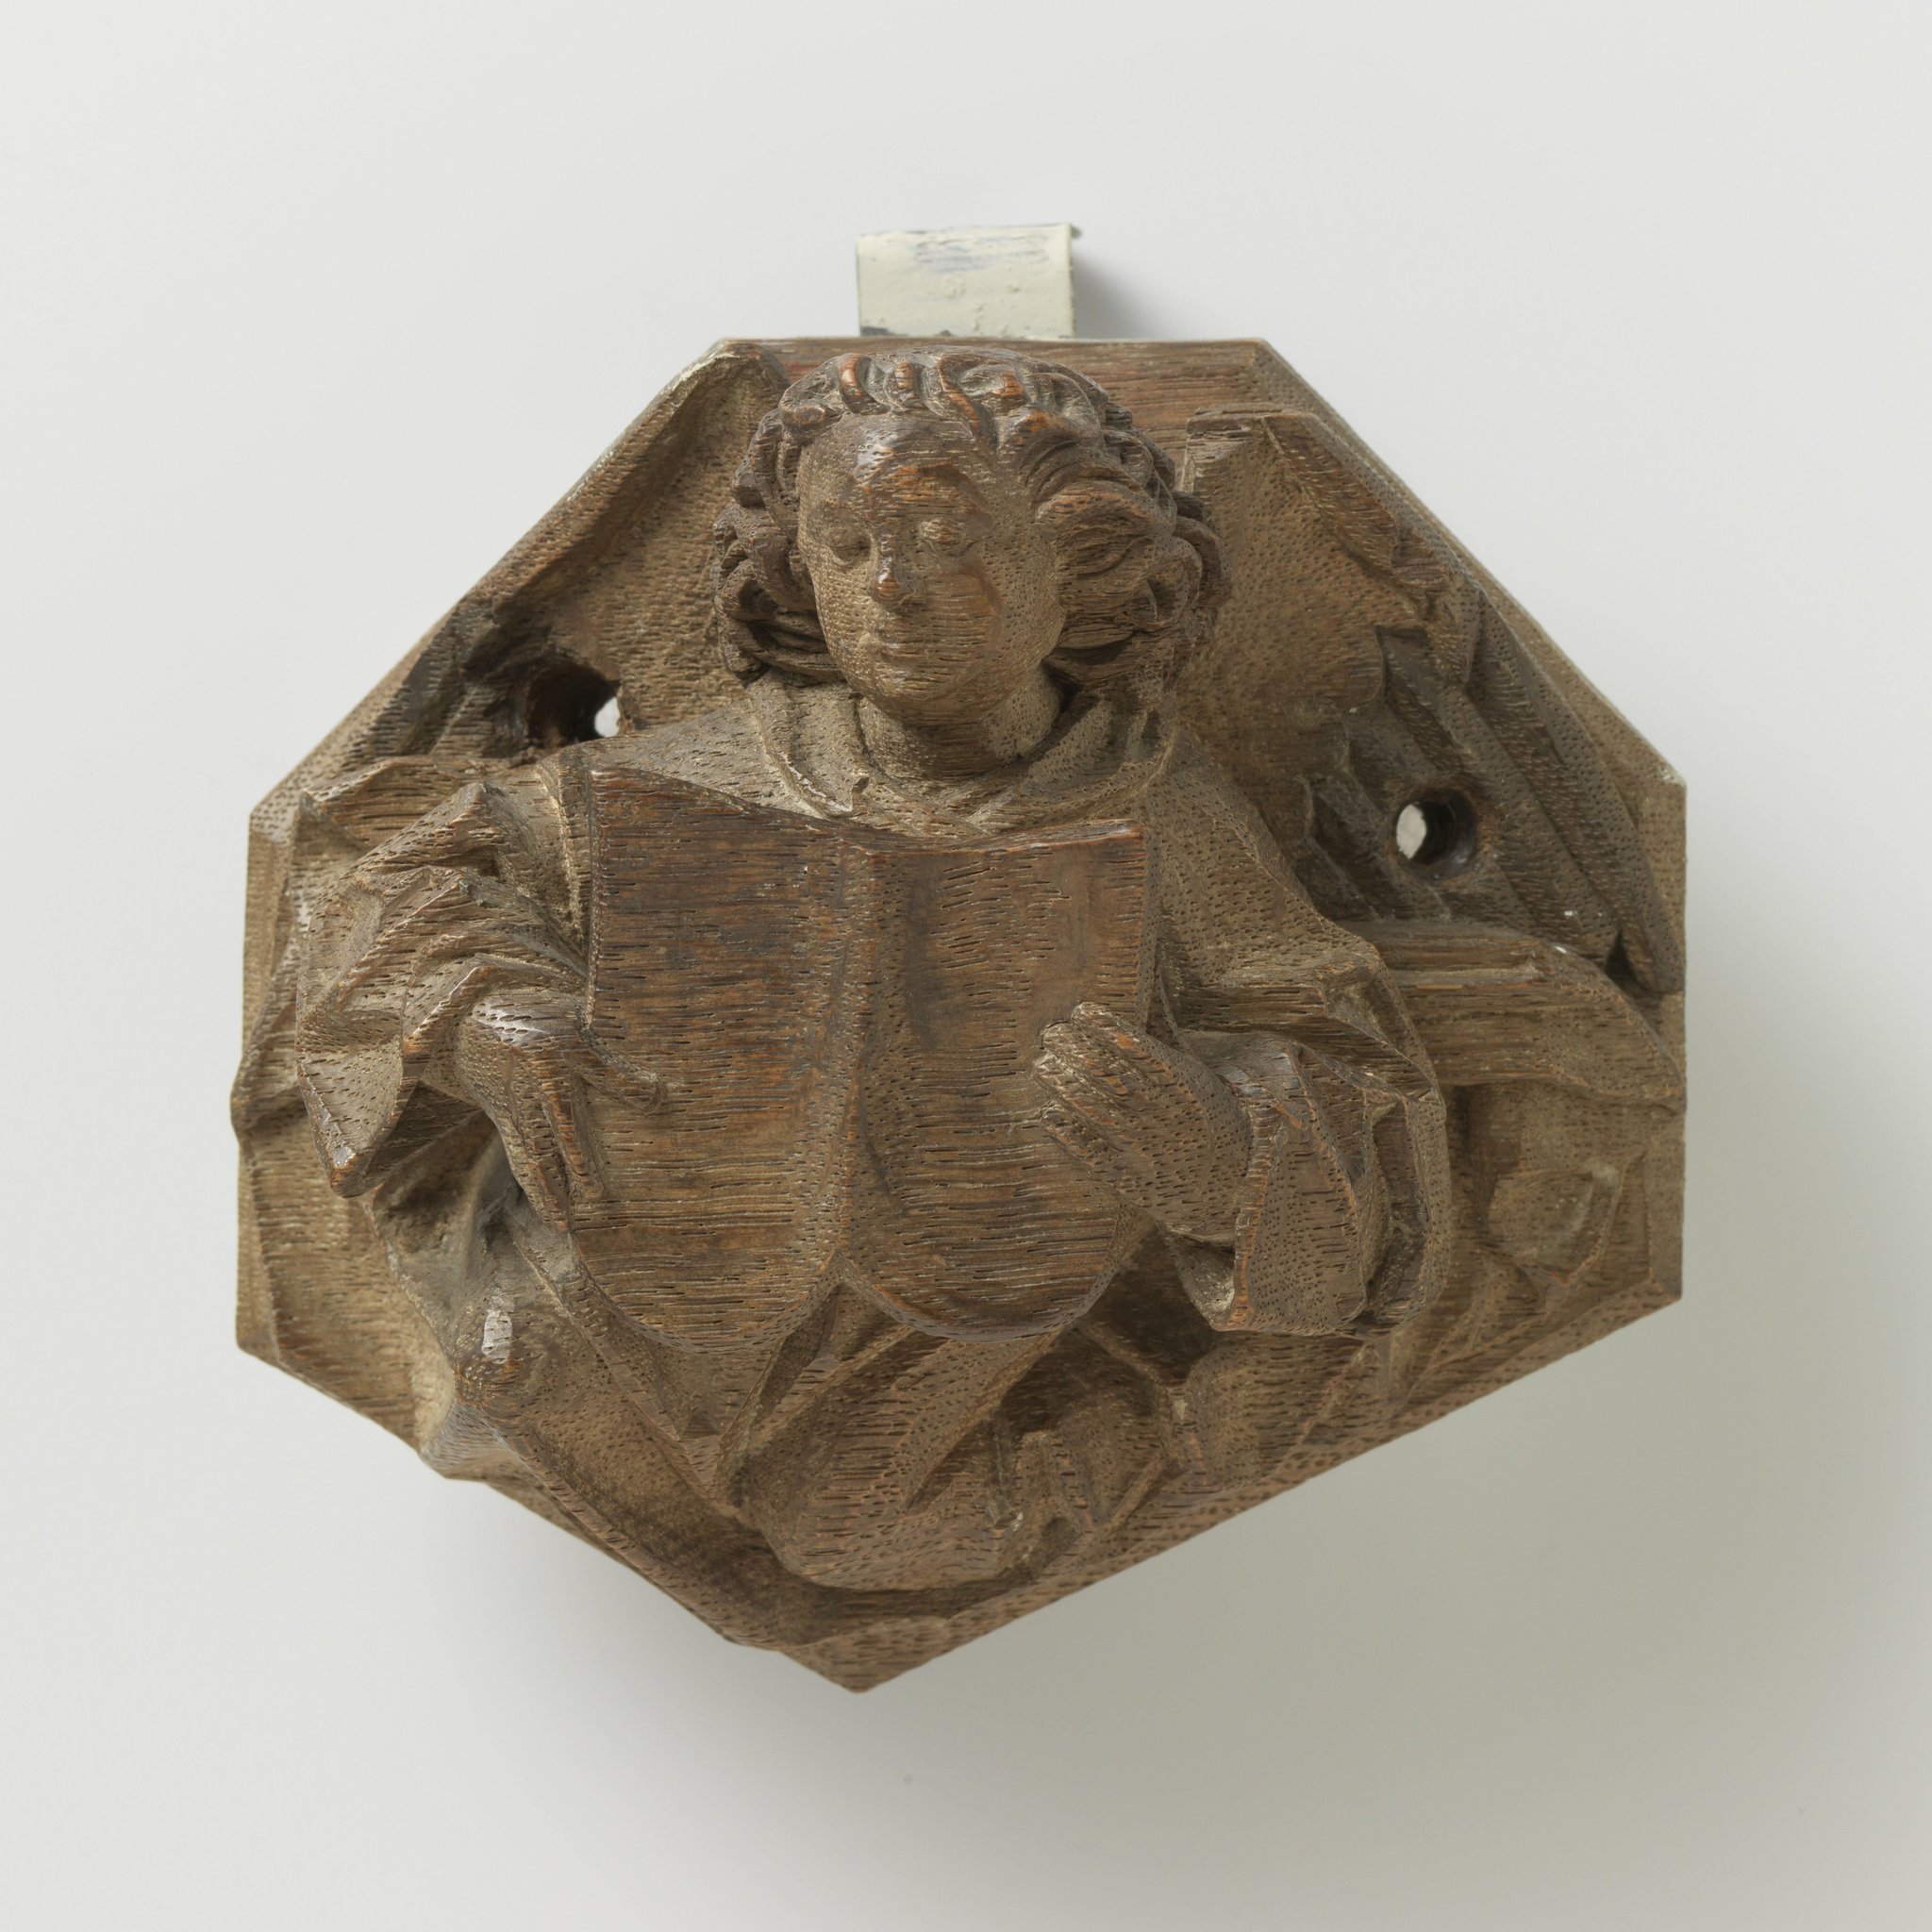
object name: roof bos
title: Roof Boss with an Angel Supporting an Escutcheon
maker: Anonymous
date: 1490-1500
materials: wood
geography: northern netherlands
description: Key-piece with an angel. Oak, originally with polychromy. Netherlands, c. 1490. On loan from the Royal Antiquarian Society.